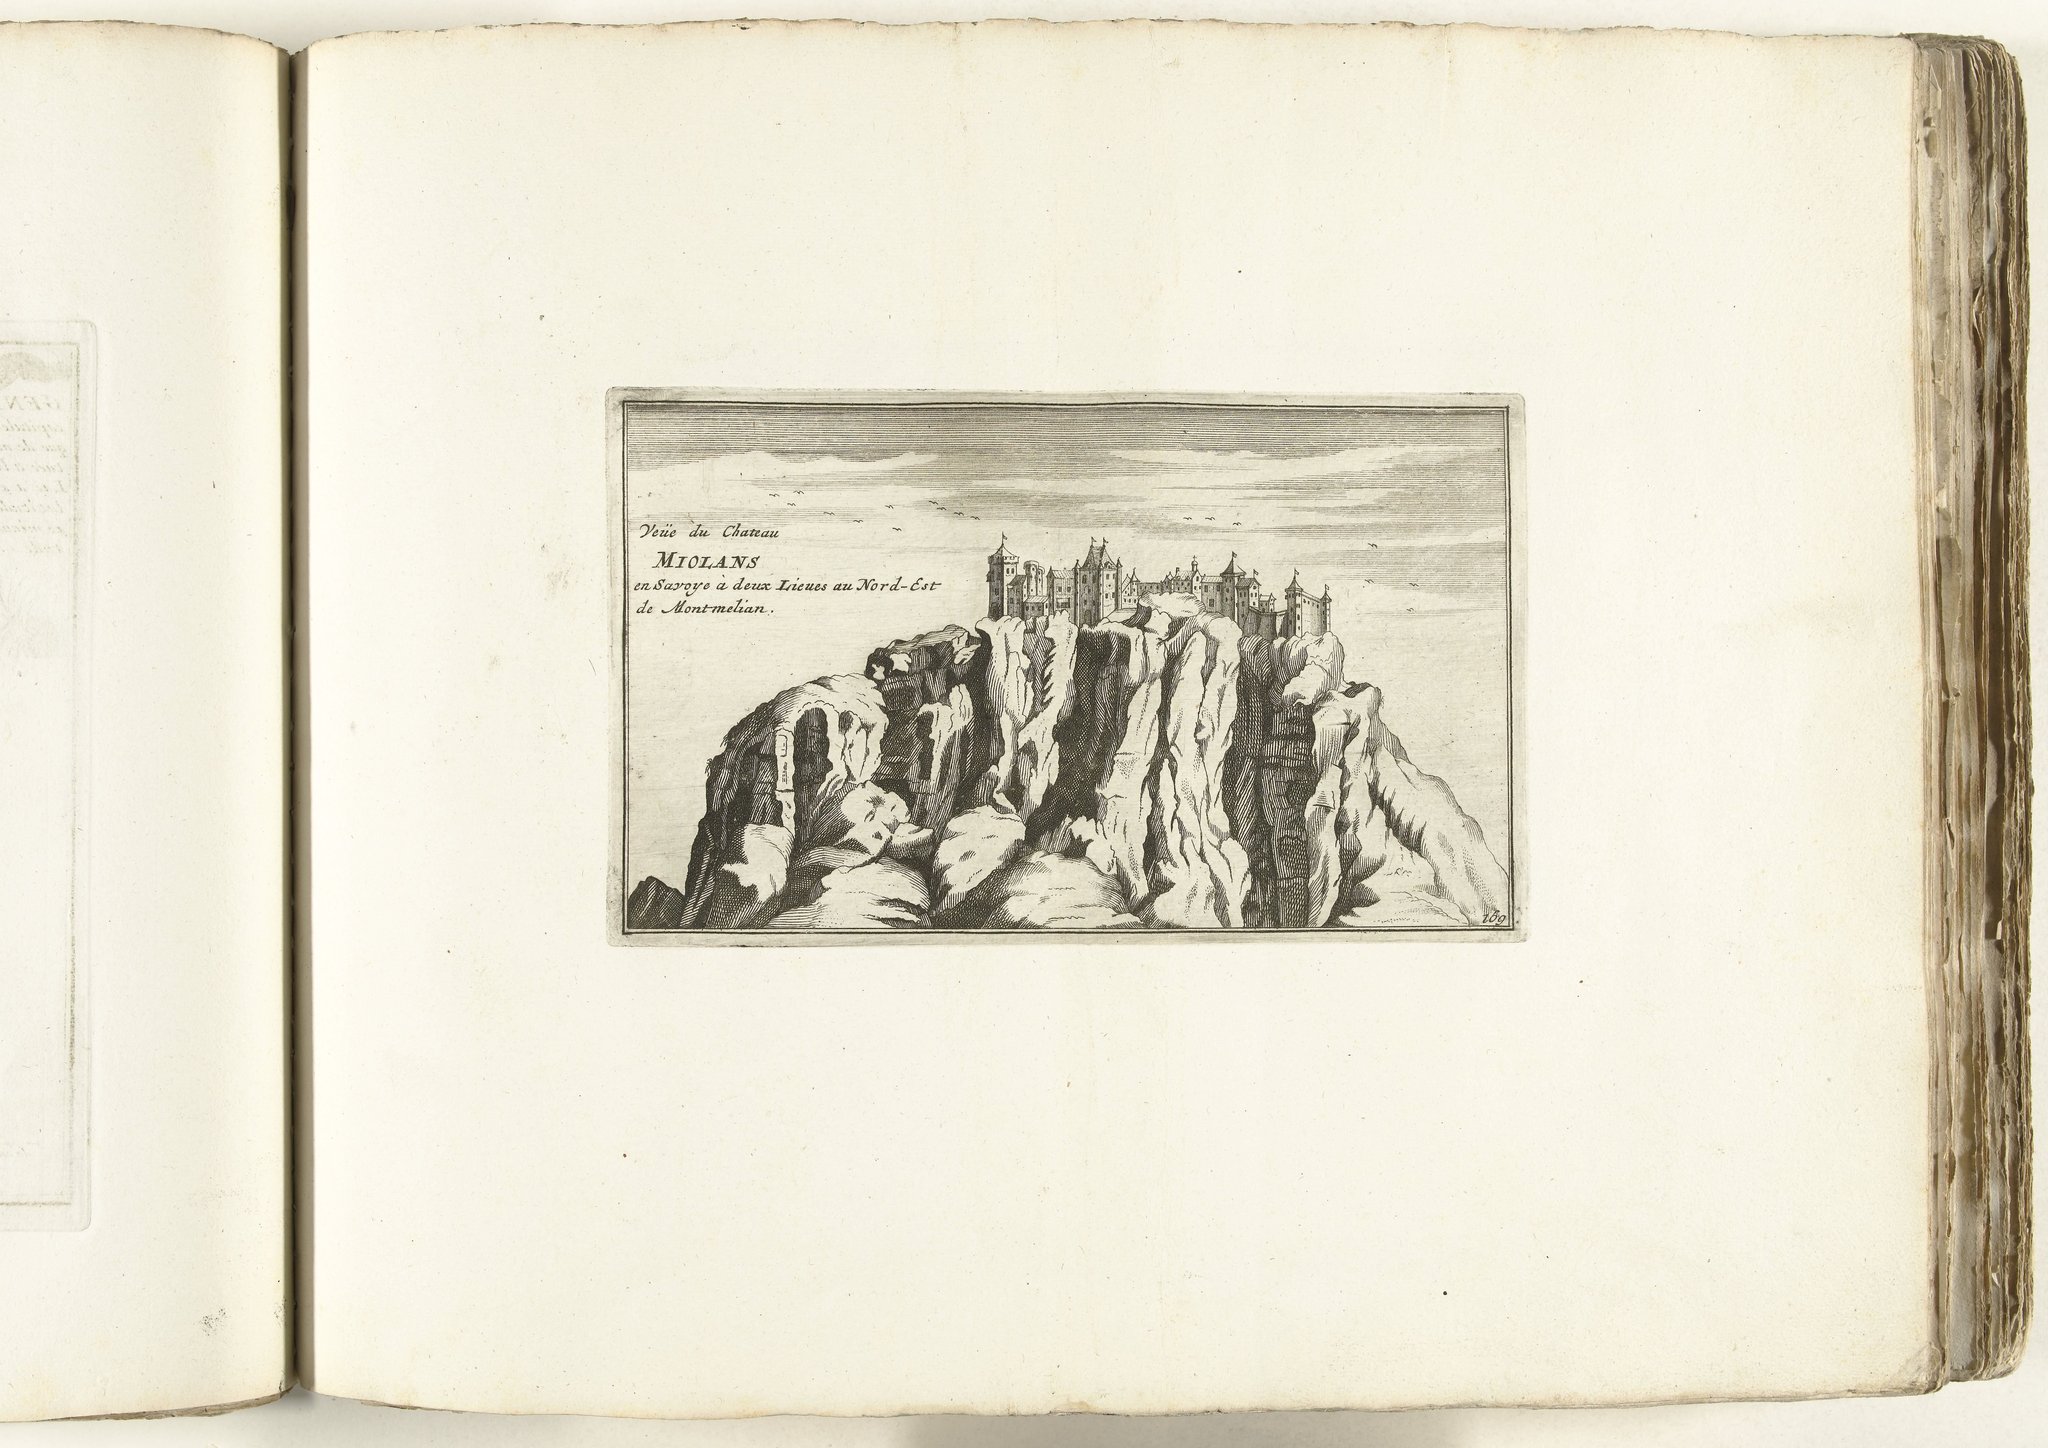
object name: print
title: Gezicht op de Château de Miolans, ca. 1702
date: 1702-1703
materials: paper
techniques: etching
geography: amsterdam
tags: fortress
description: Gezicht op de Franse Château de Miolans, nabij Montmélian. Plaat nr. 169 in het prentwerk bestaande in totaal uit 276 genummerde platen van vermaarde sterke steden en vestingen in het kader van de Spaanse Successieoorlog. Voor het merendeel zijn deze platen gekopieerd naar de anonieme Franse platen: in Les forces de l'Europe en in: Le theatre de la guerre, dans les Pays-Bas, beide oorspronkelijk uitgegeven door Nicolas de Fer te Parijs (1693-1697) in het kader van de Negenjarige Oorlog. Titel en opschriften in de plaat in het Frans.